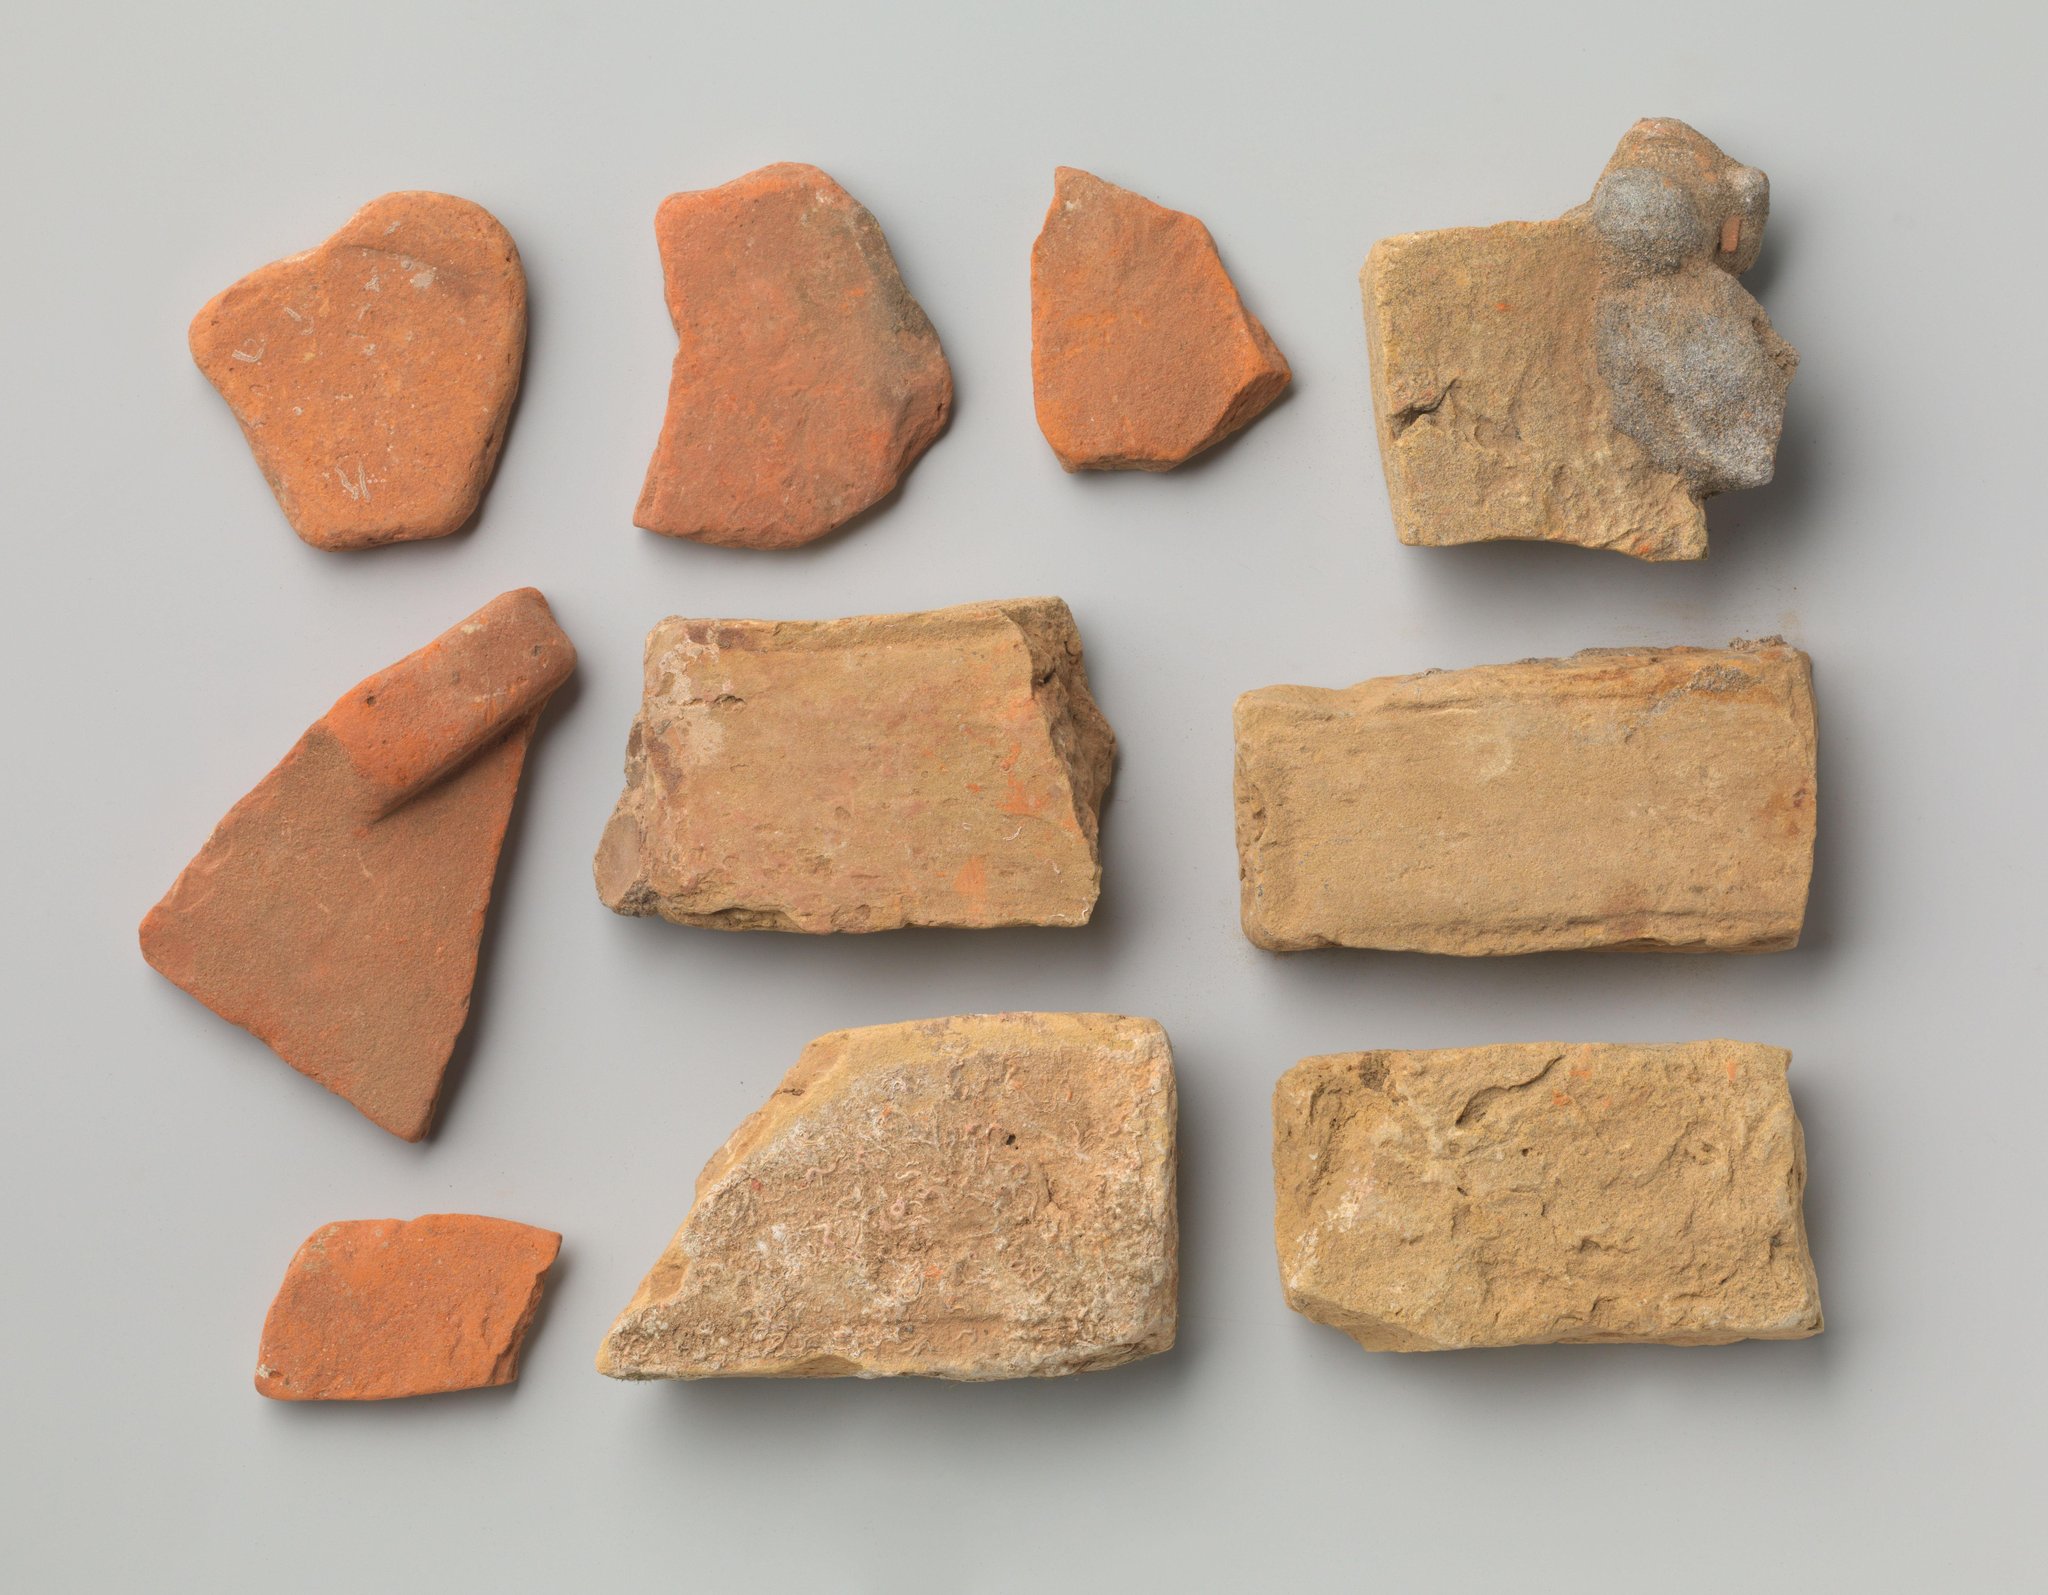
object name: roof tile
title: Fragmenten van daktegels en bakstenen uit V.O.C.-schip Zeelelie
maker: Anonymous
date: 1795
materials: brick, earthenware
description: Fragmenten van daktegels en bakstenen, roodbakkend en geelbakkend.